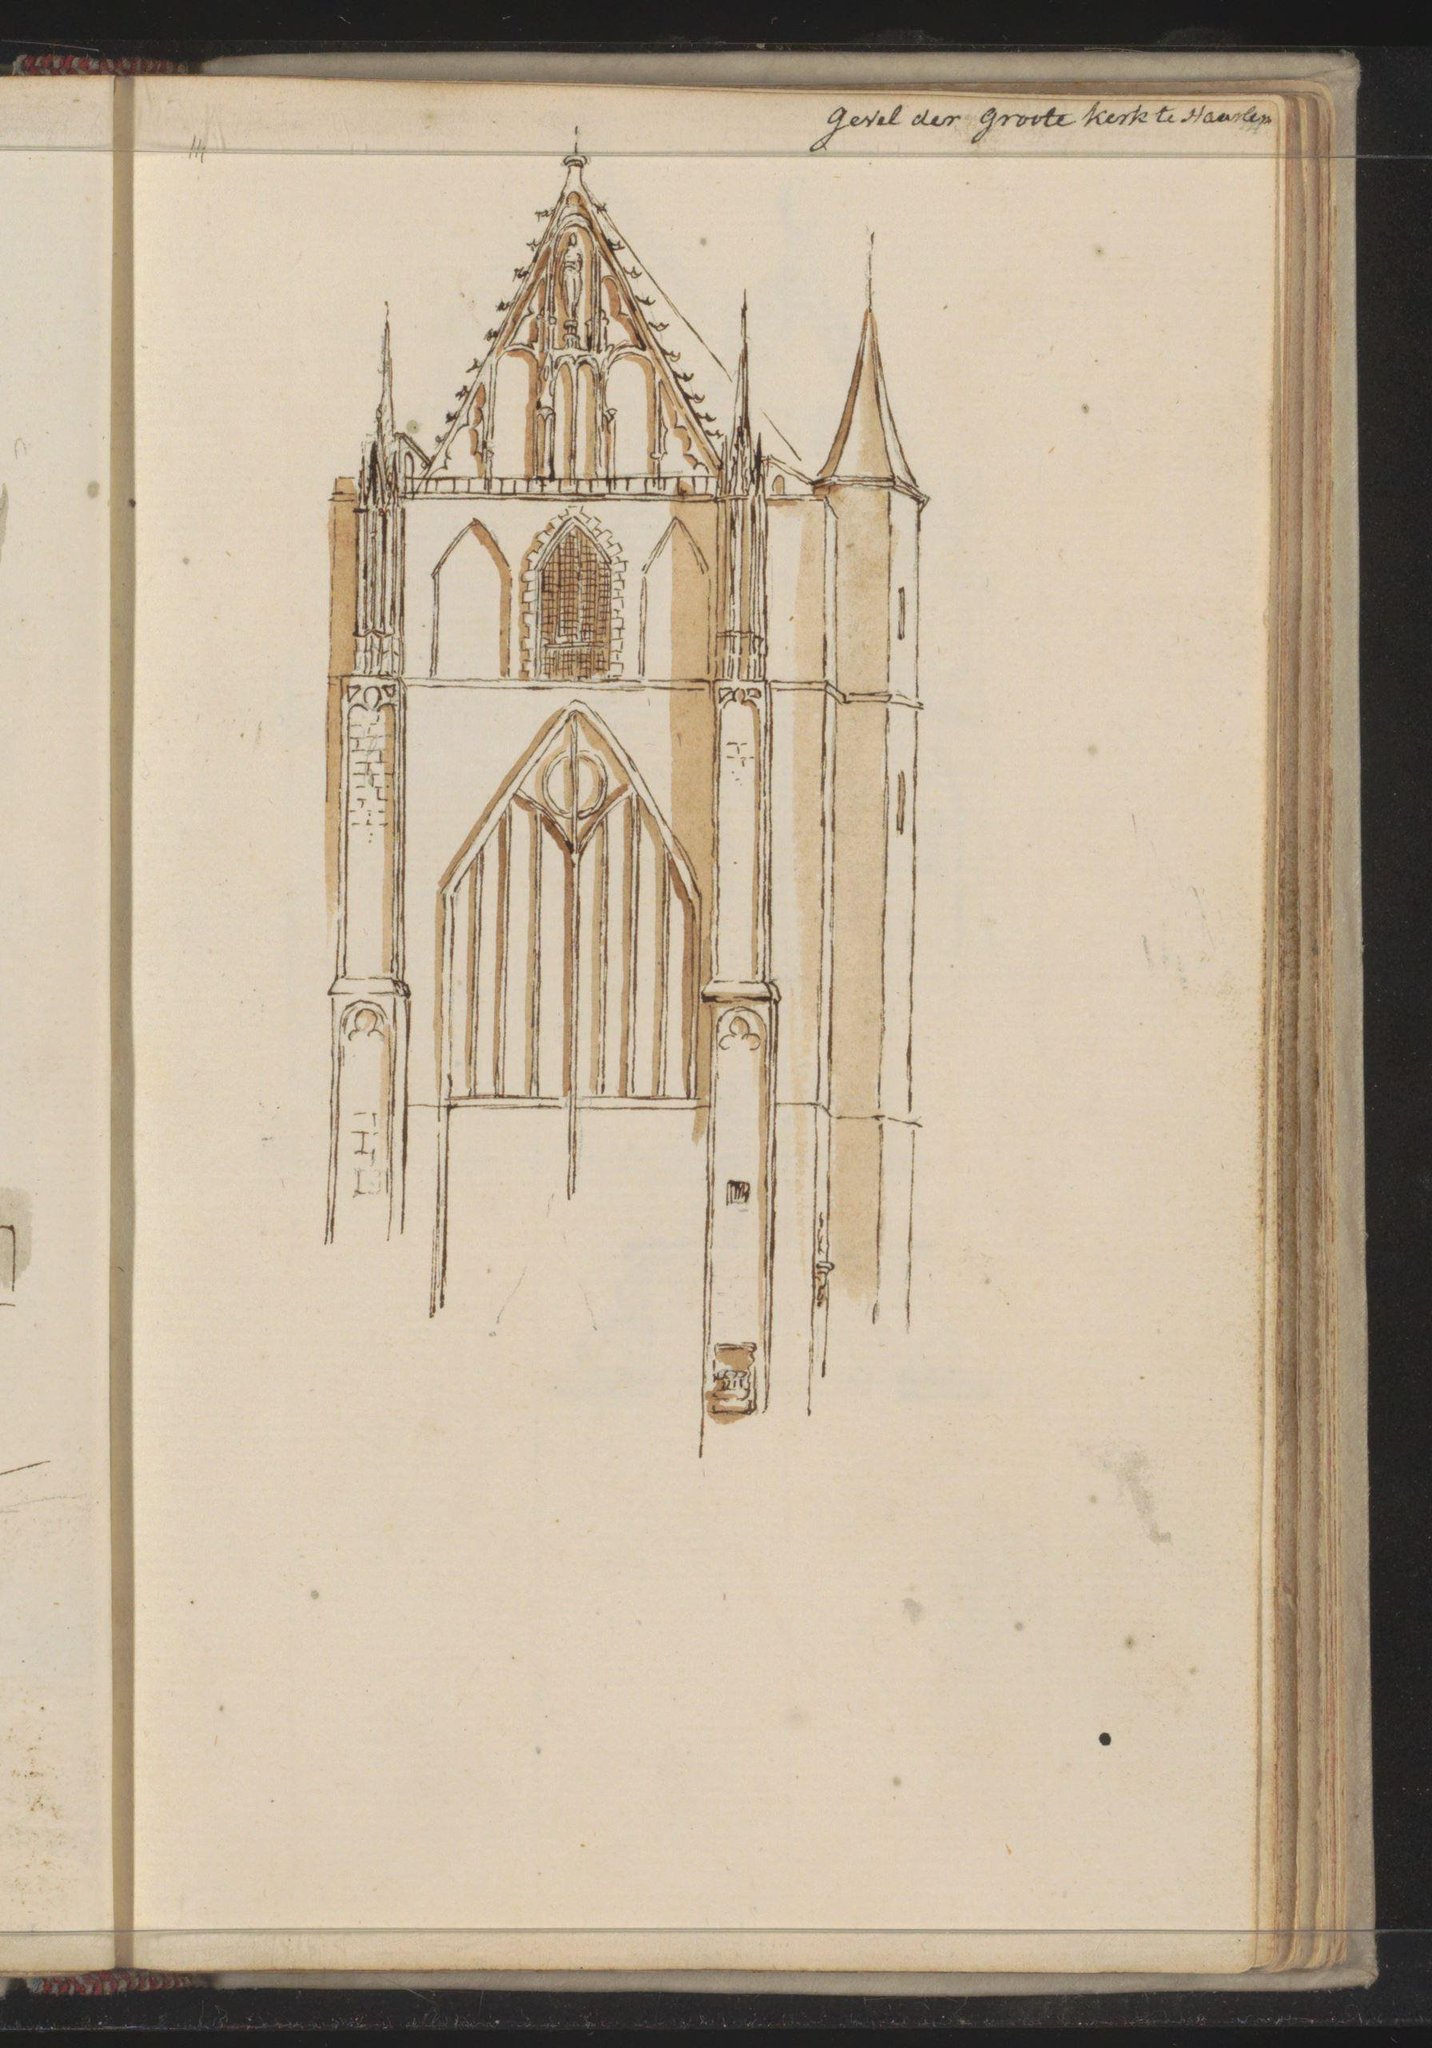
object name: sketchbook leaf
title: Gevel van de Grote Kerk te Haarlem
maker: johannes huibert prins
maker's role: draughtsman, painter, print maker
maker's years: 1757-1806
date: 1783-1797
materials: ink, paper, pencil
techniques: brush, pen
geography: haarlem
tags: parts of church exterior and annexes: façade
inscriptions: annotation: ‘gevel der groote kerk te Haarlem’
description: Pagina 74 uit een schetsboek met 175 pagina's.